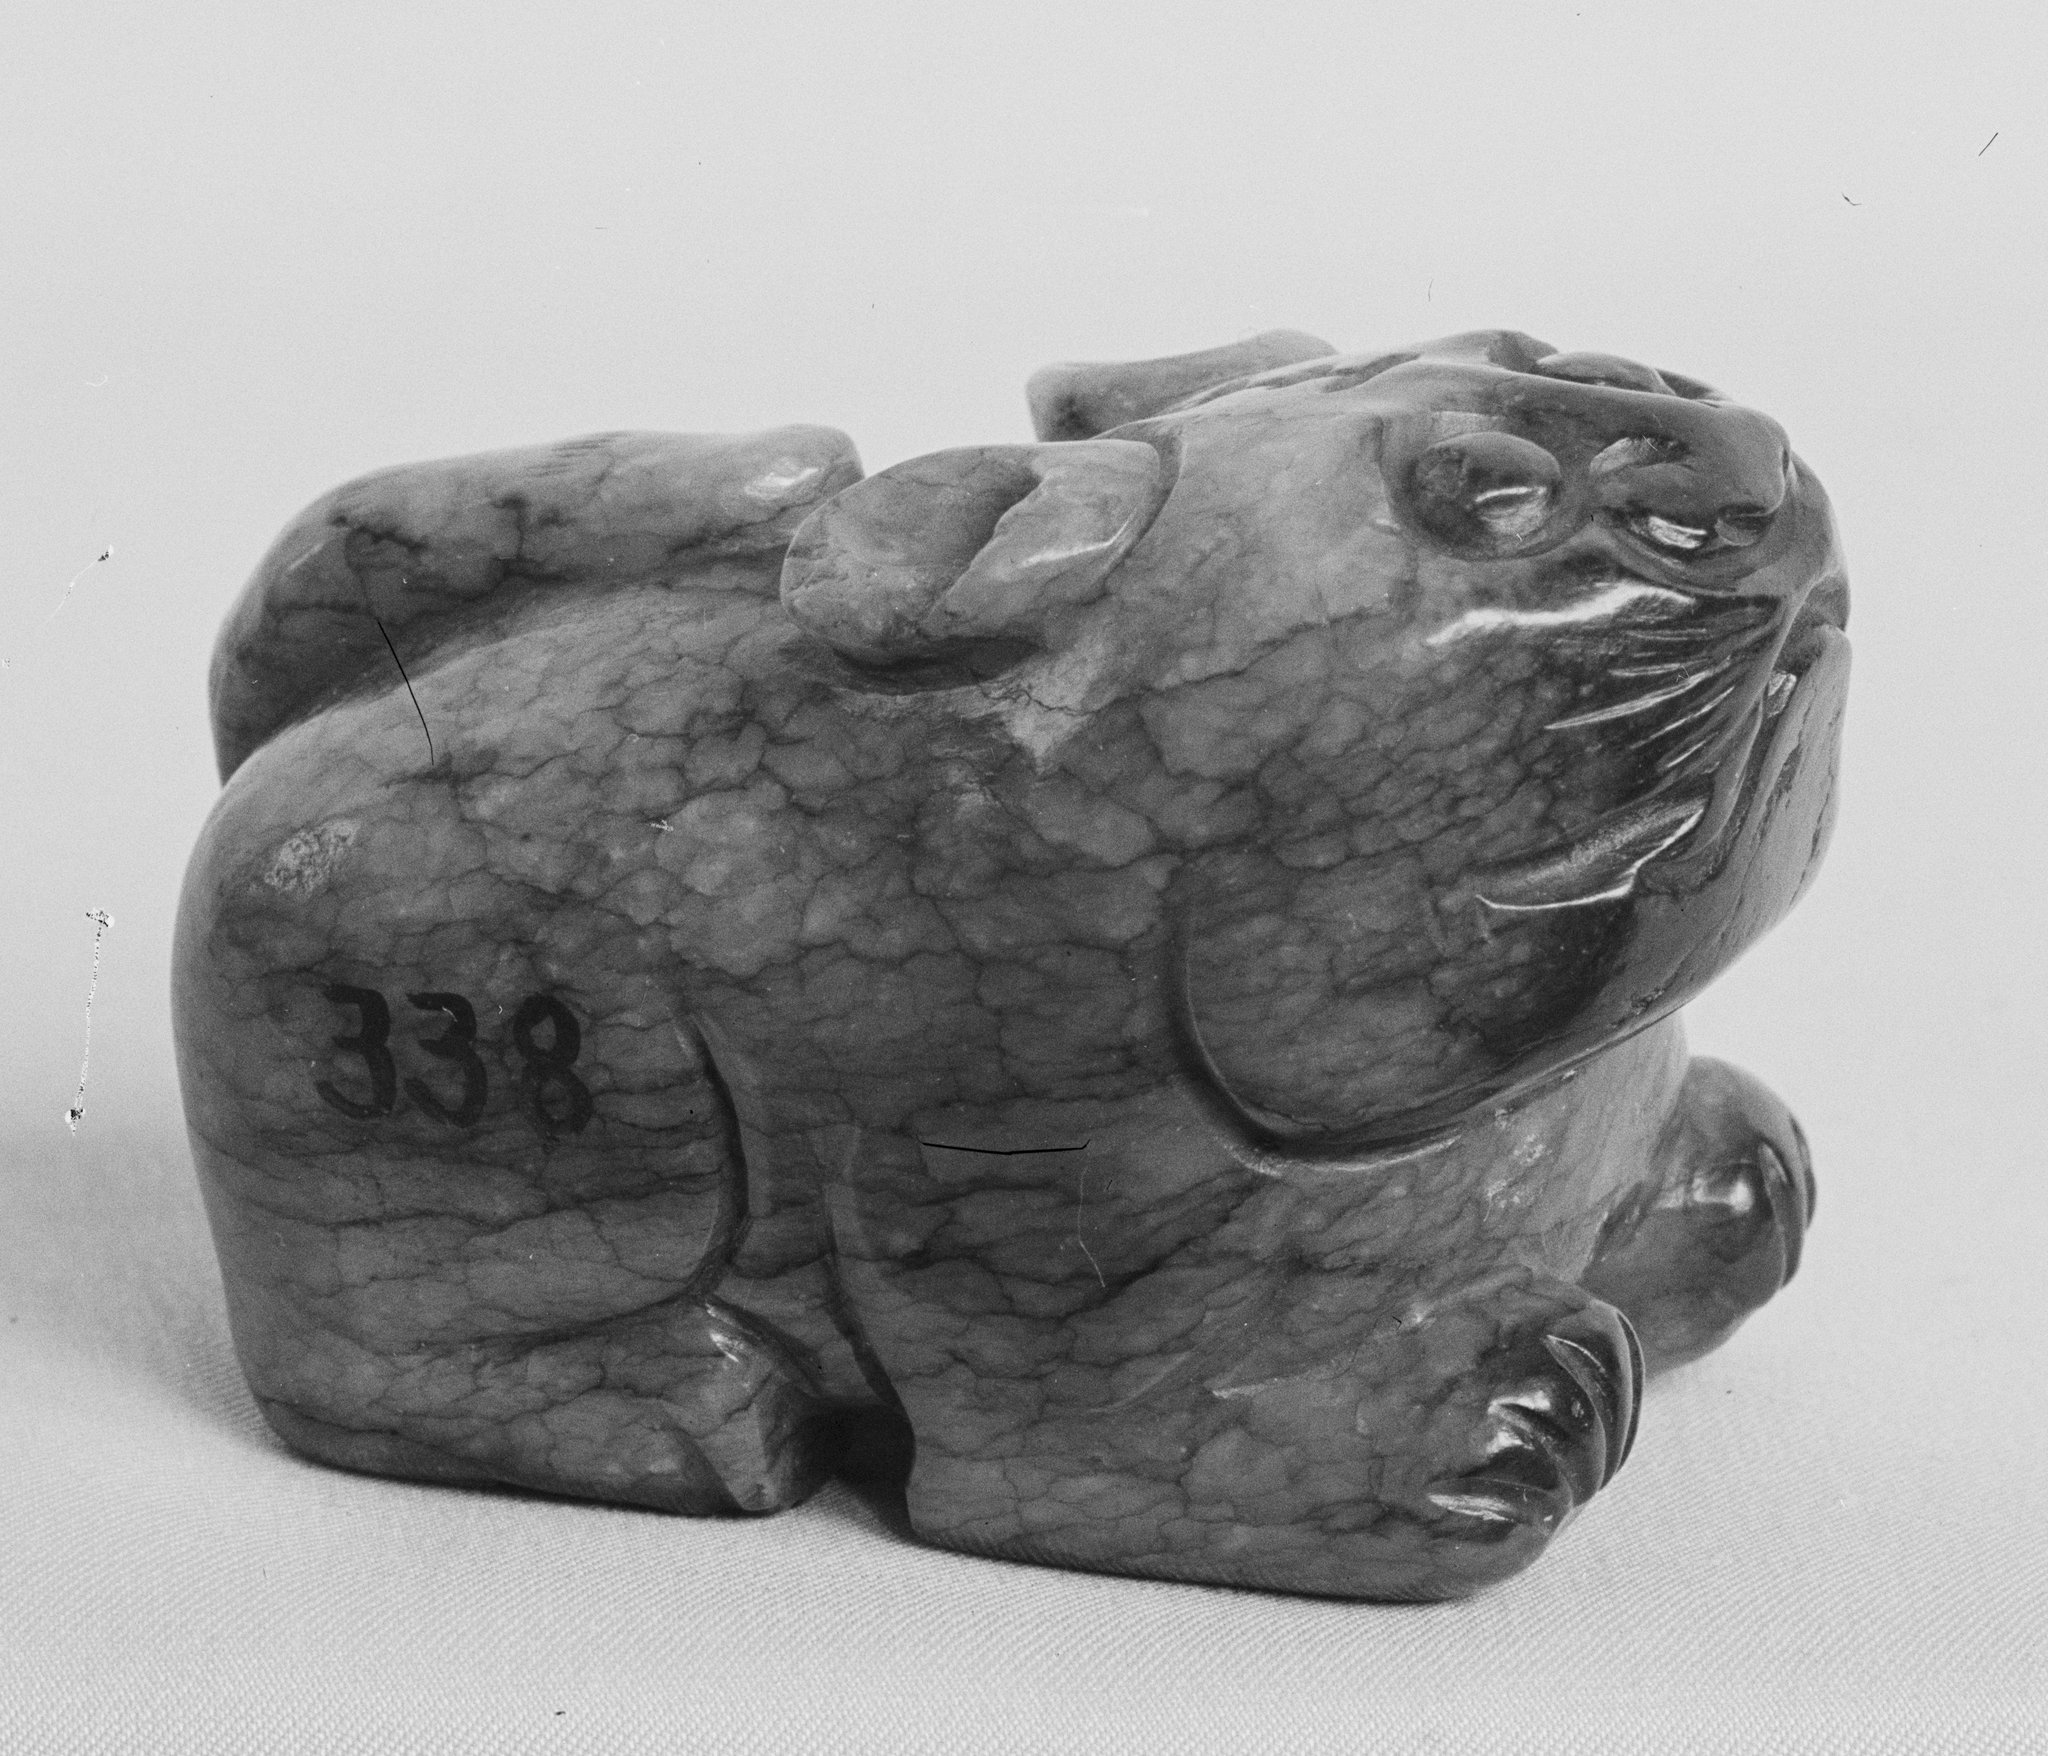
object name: girdle appendage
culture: chinese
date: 1201-1300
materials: jade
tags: rabbits